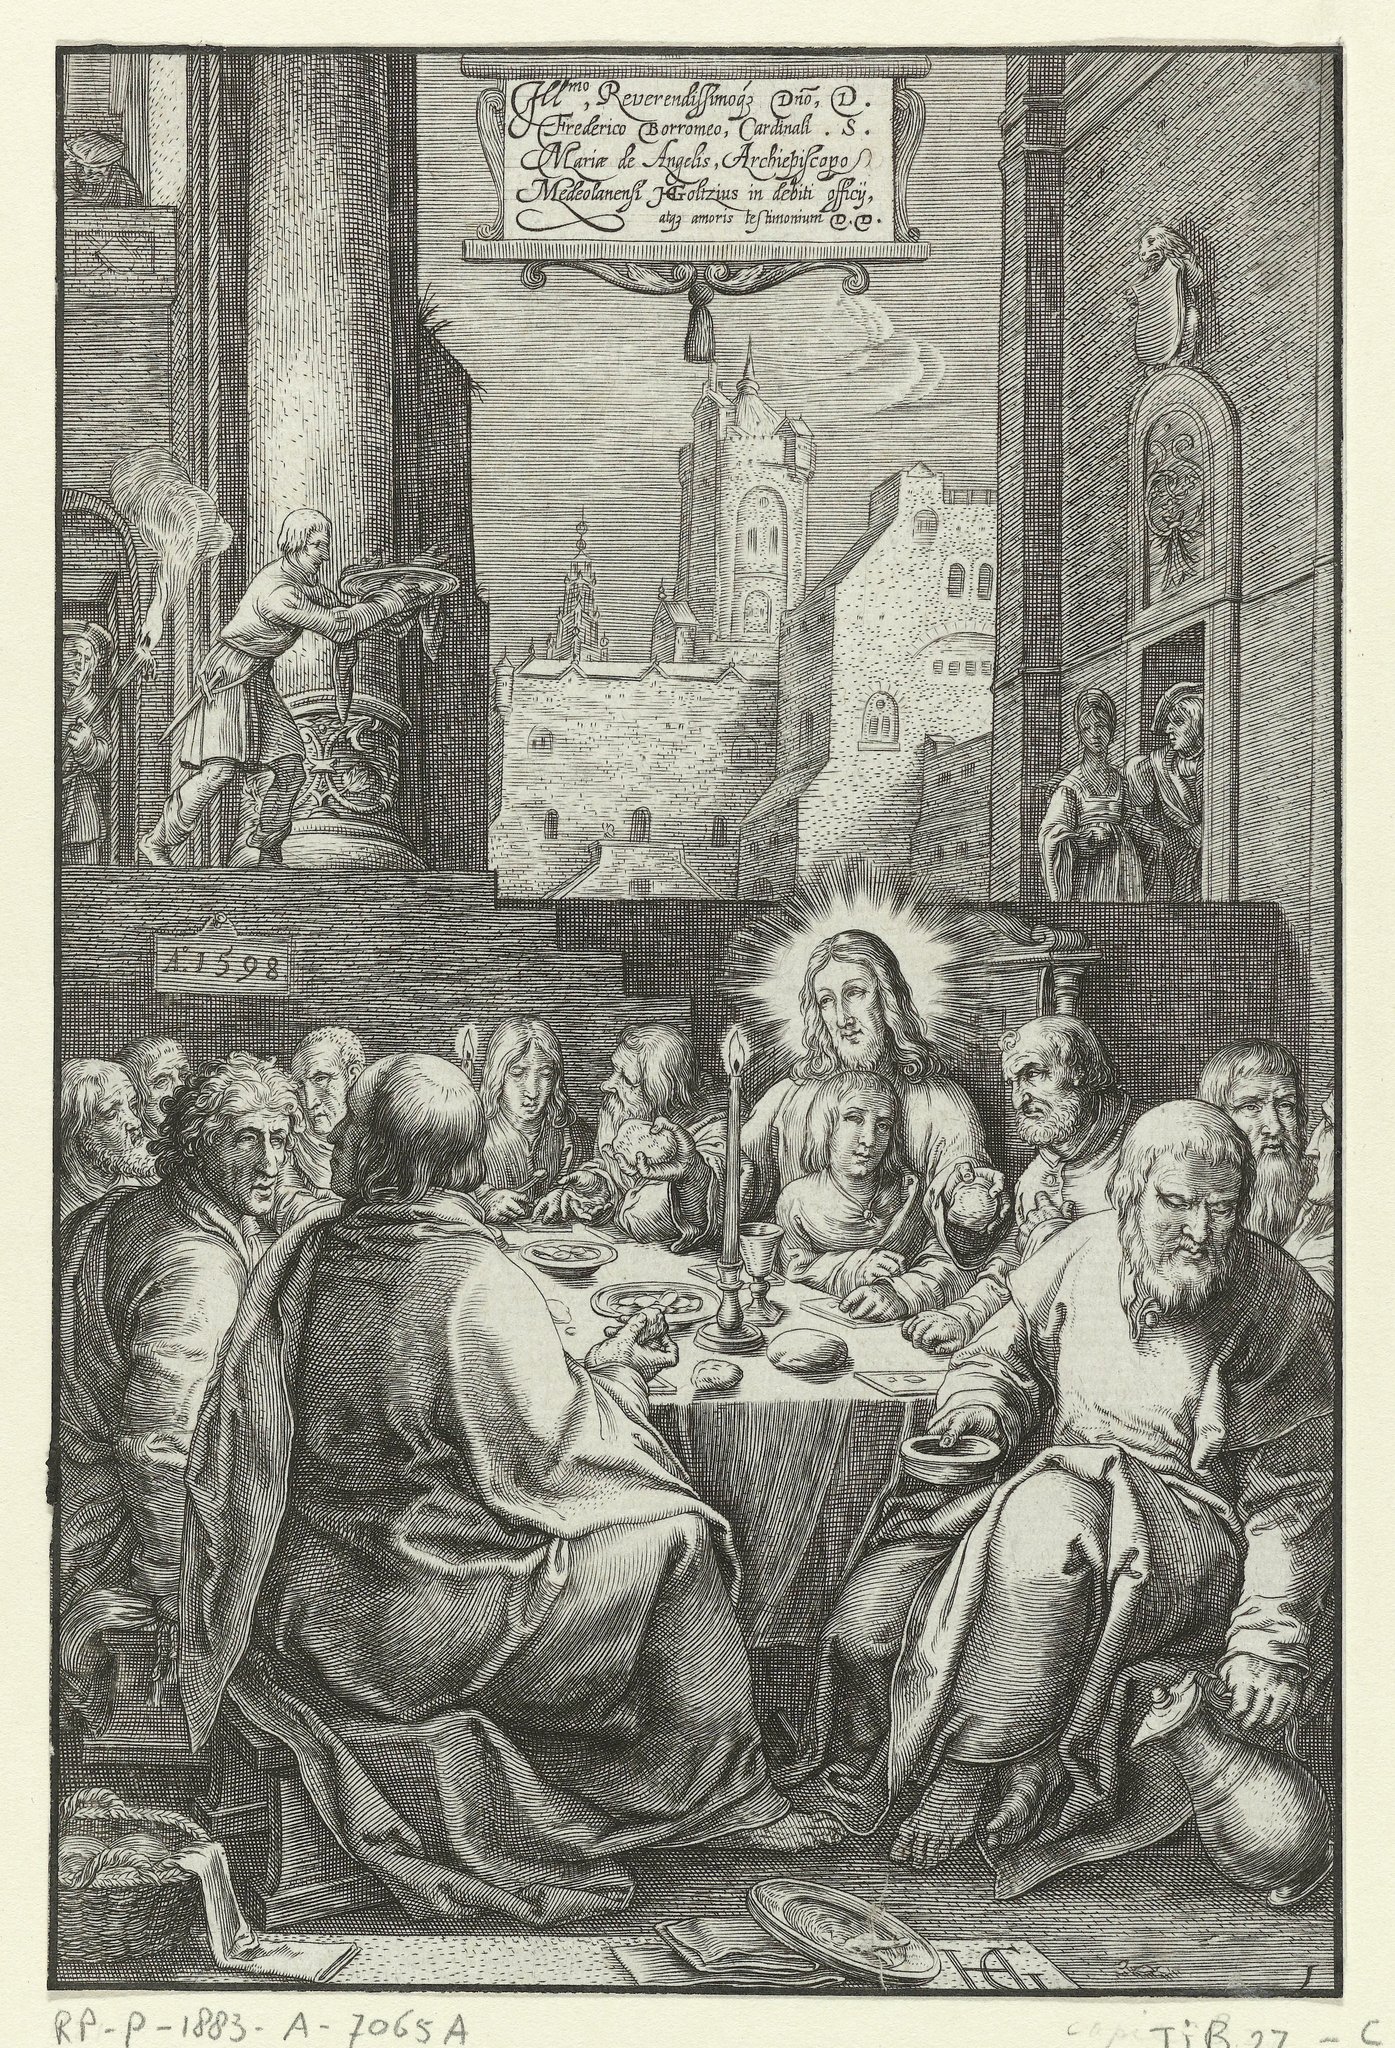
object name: print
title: De Passie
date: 1598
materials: paper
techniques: engraving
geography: antwerp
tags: last supper (in general) (matthew 26:21-35; mark 14:18-31; luke 22:3, 22:15-23; john 13:21-38)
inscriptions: collector's mark: Lugt 2228a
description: Christus gebruikt met zijn discipelen het Laatste Avondmaal in een architectonische omgeving. Deze prent is onderdeel van een serie van twaalf passievoorstellingen.